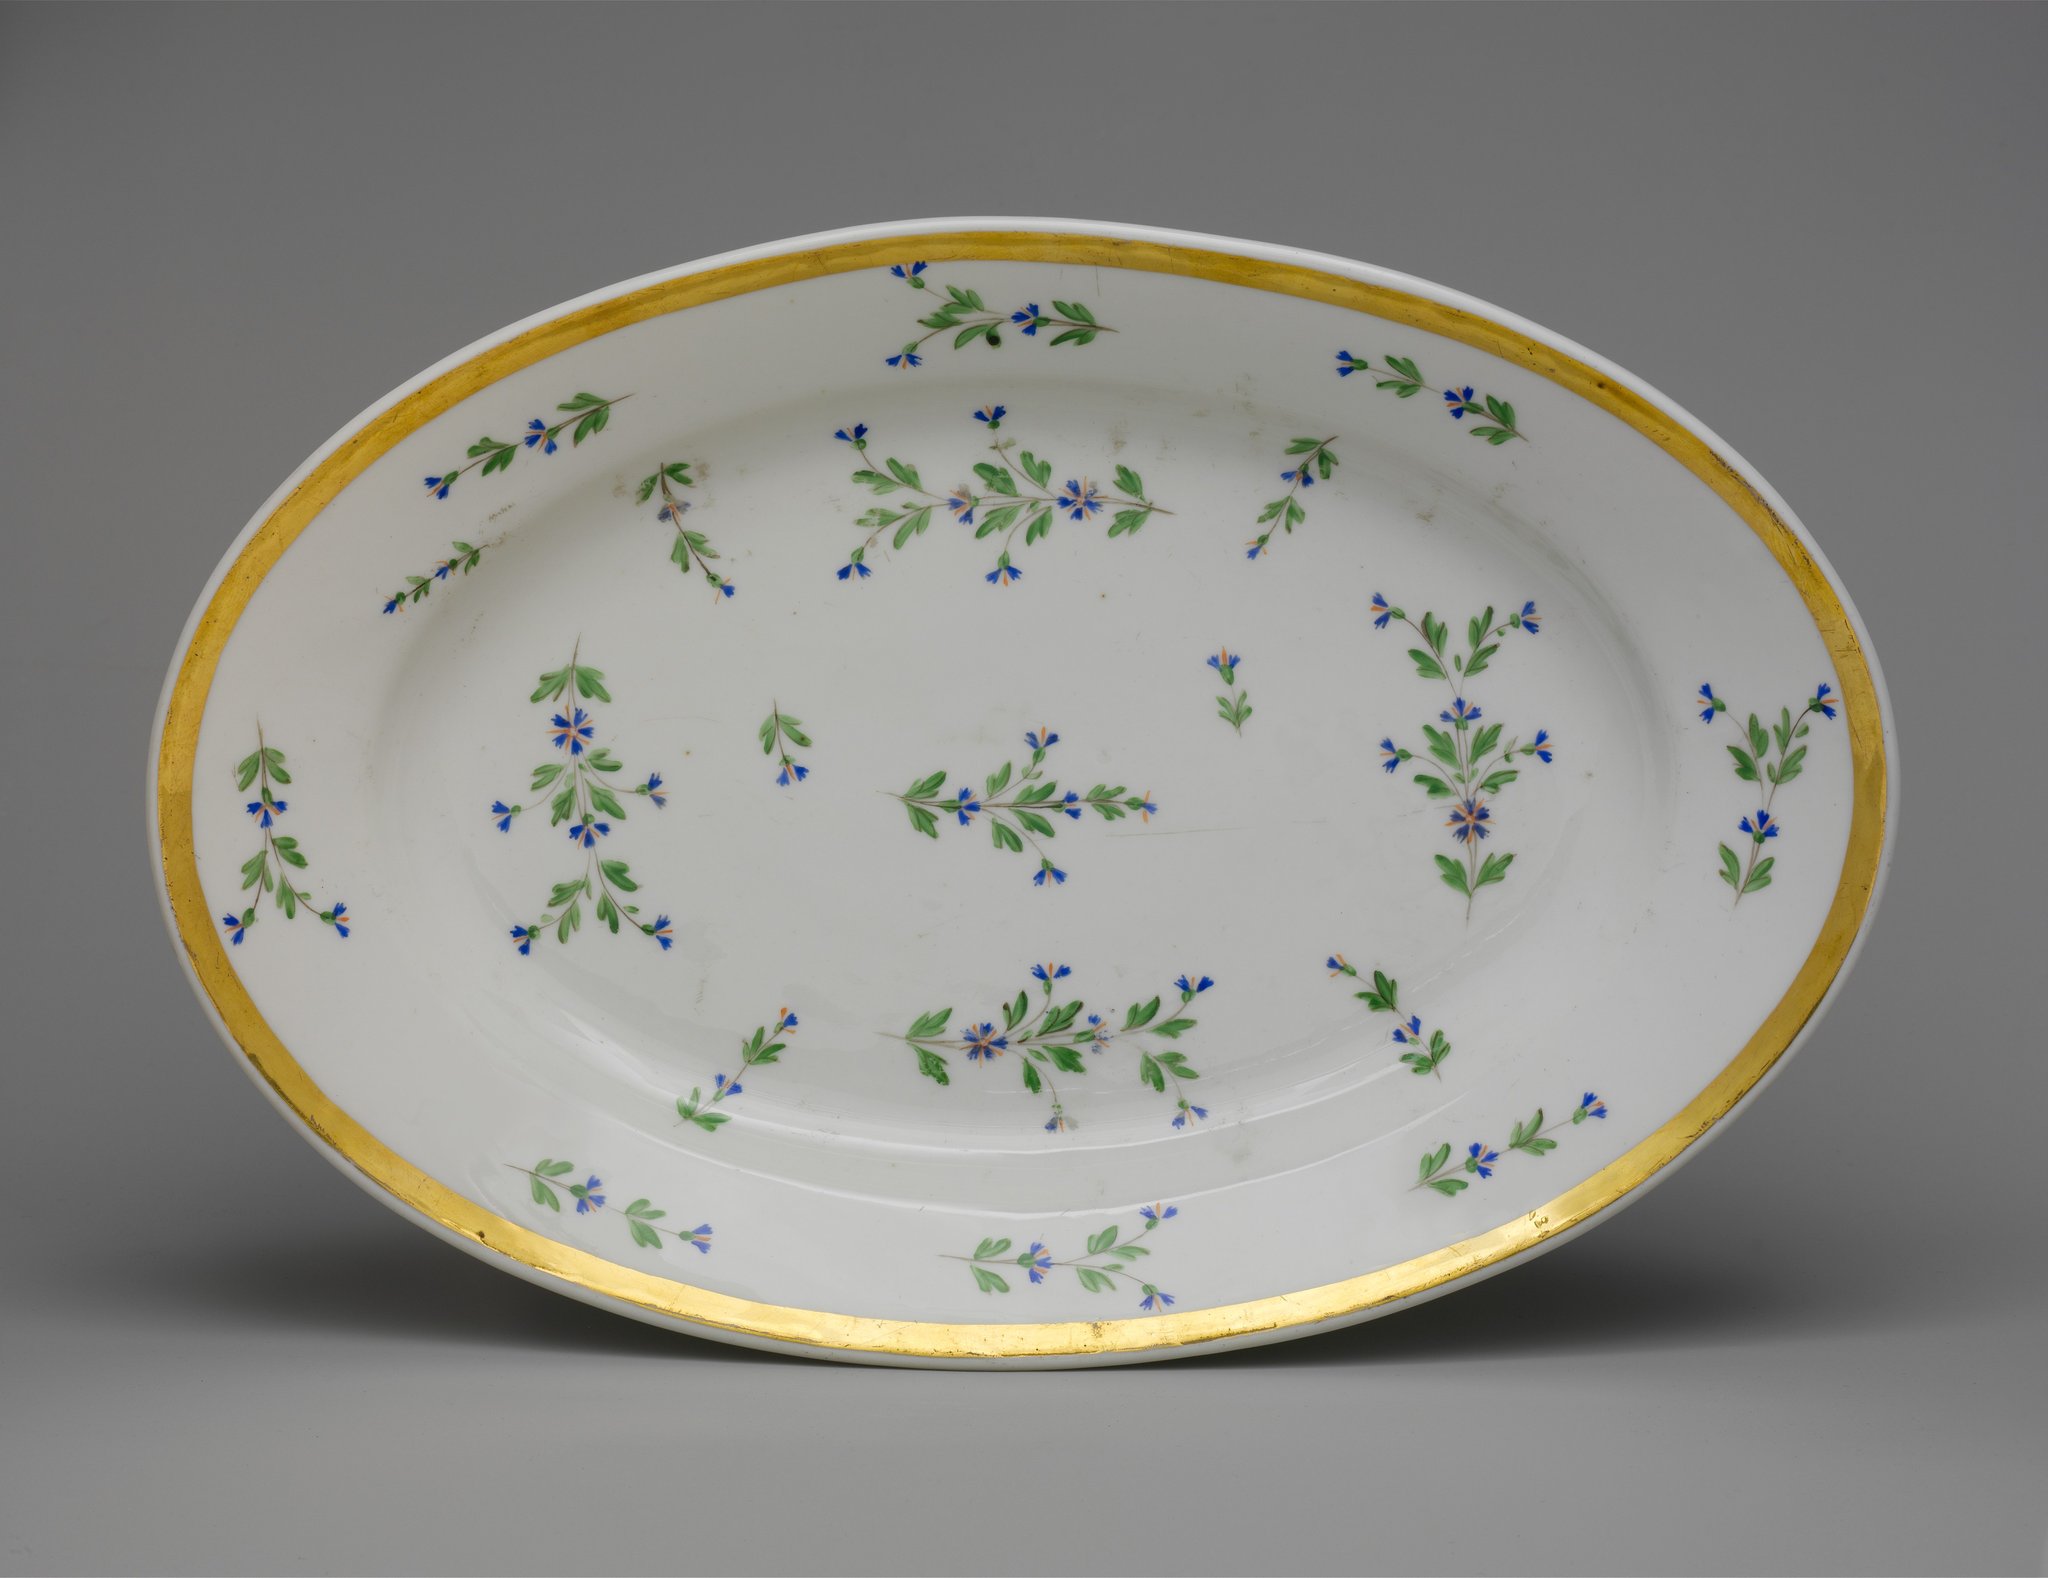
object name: platter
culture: french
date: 1815-1830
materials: porcelain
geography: france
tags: flowers